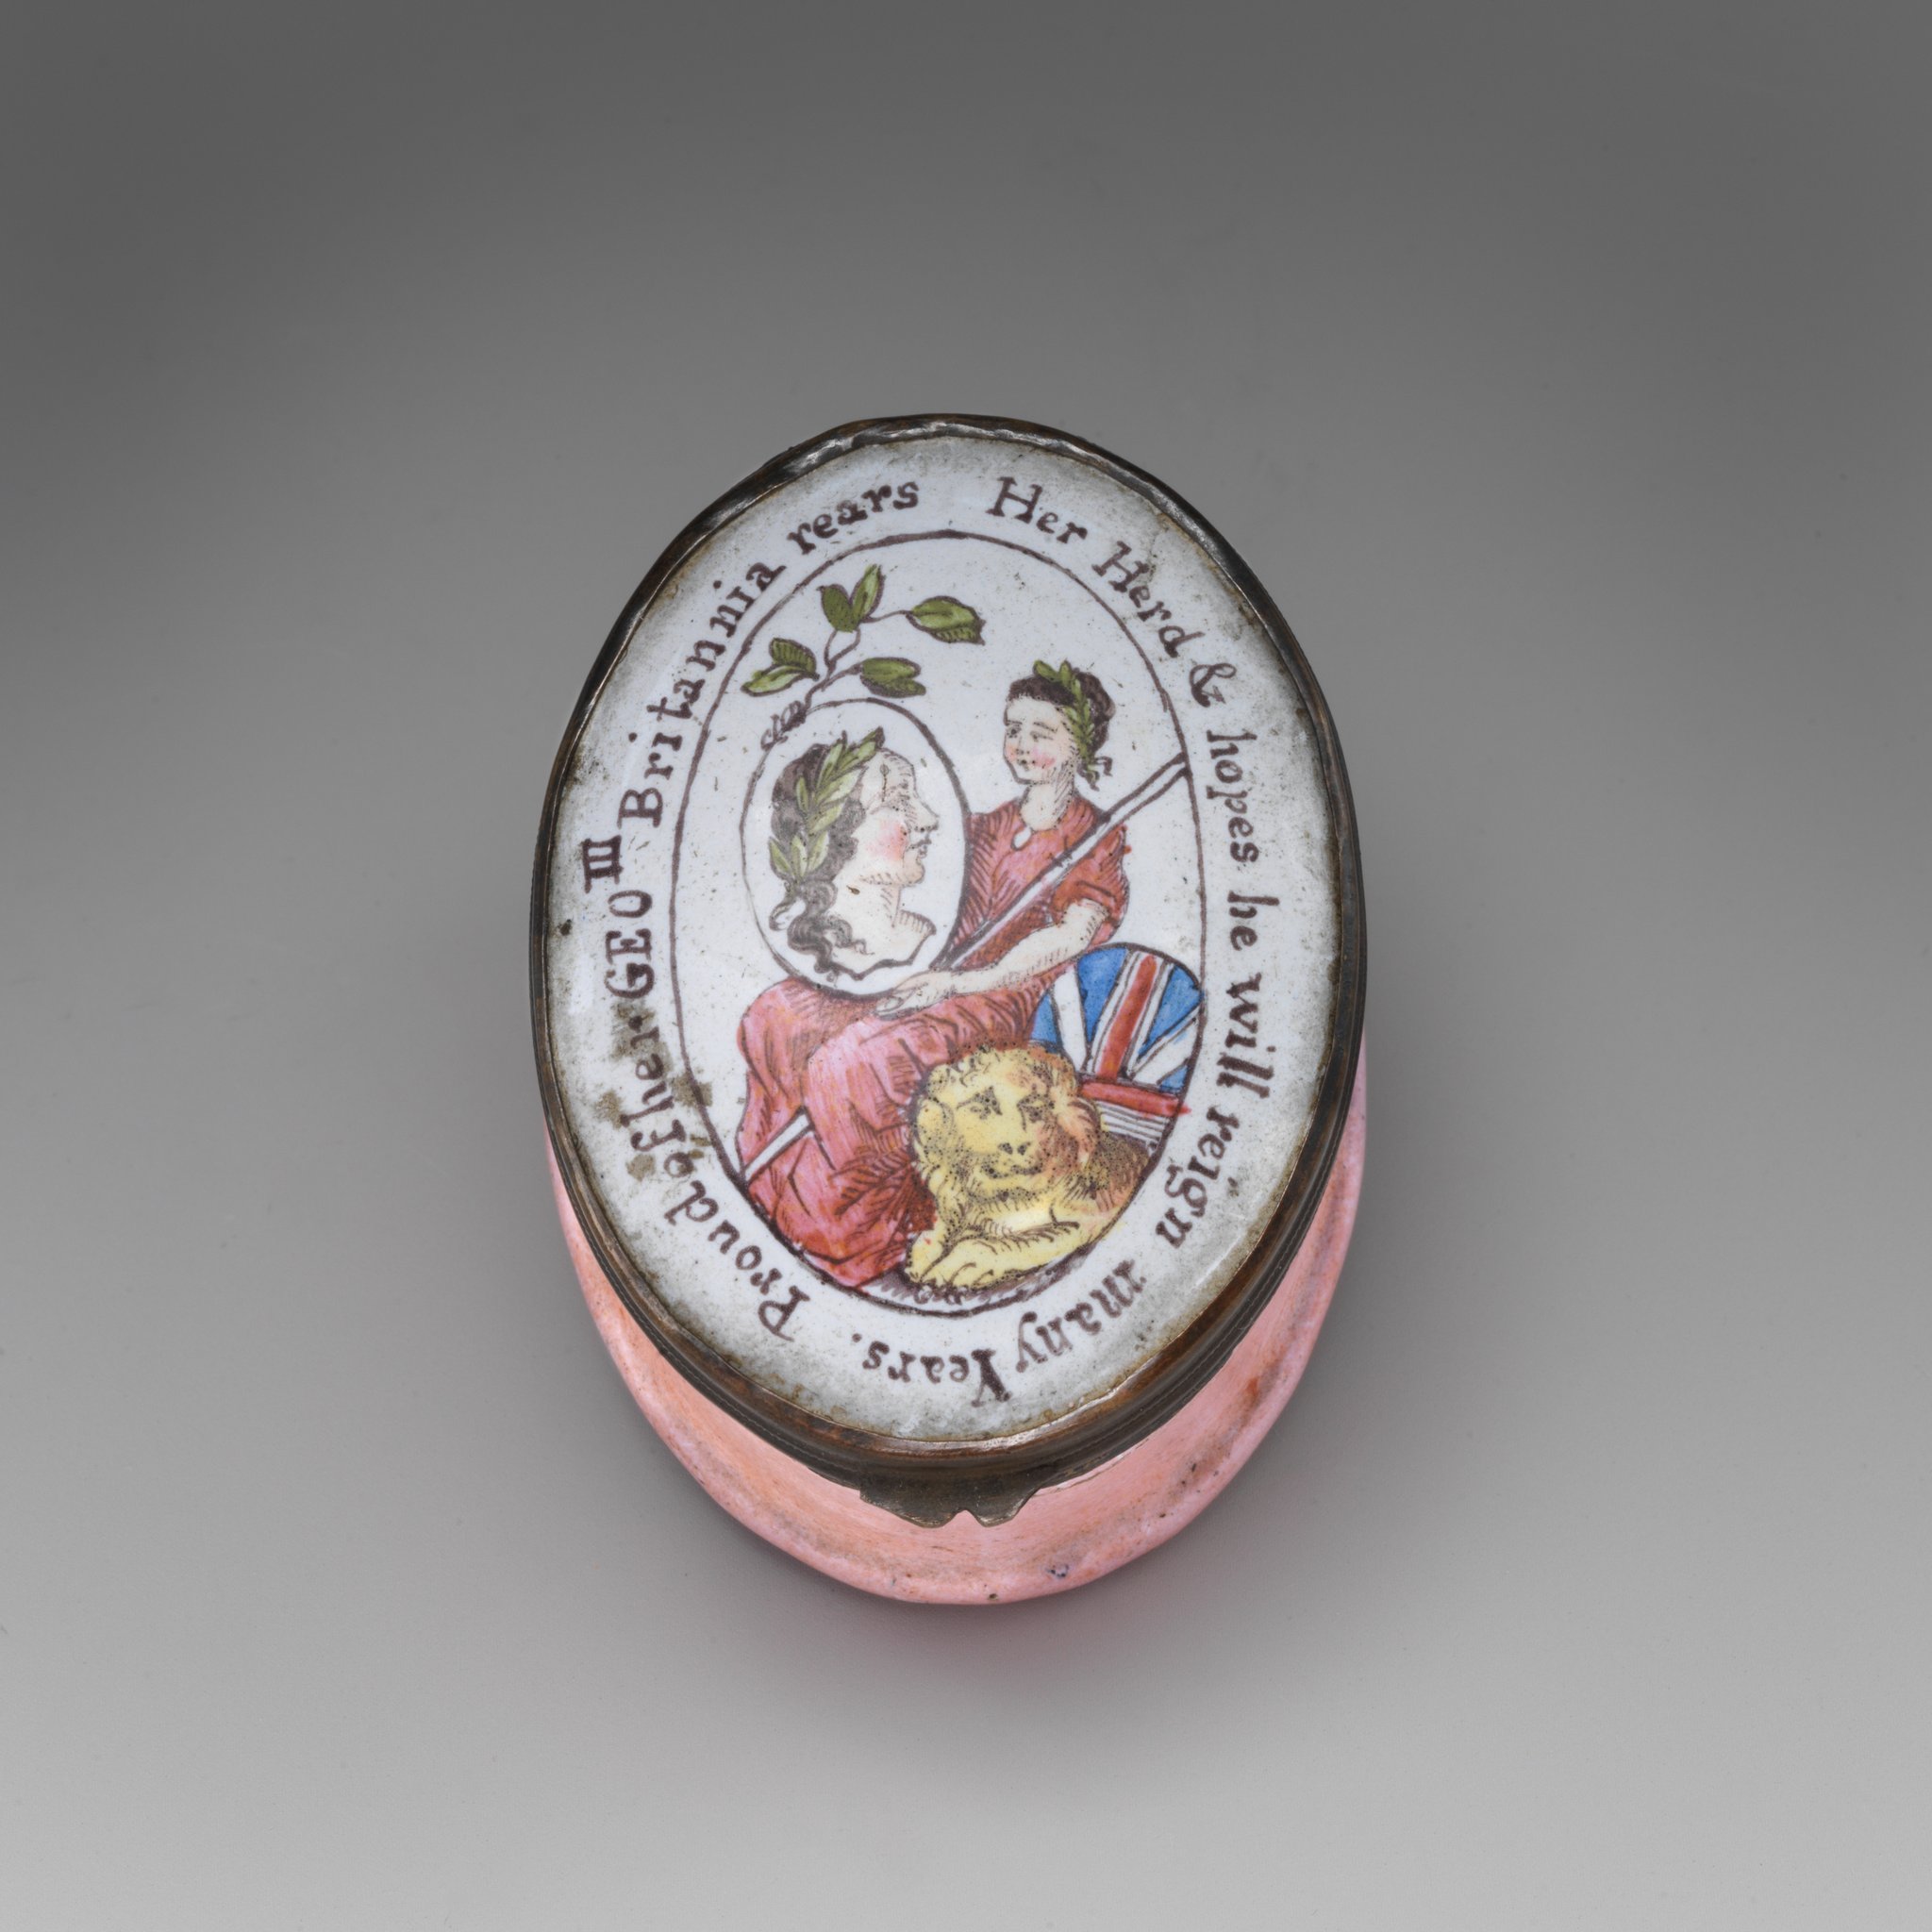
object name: patch box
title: Patch box celebrating King George III’s recovery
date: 1789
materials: copper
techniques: enamel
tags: human figures,profiles,lions